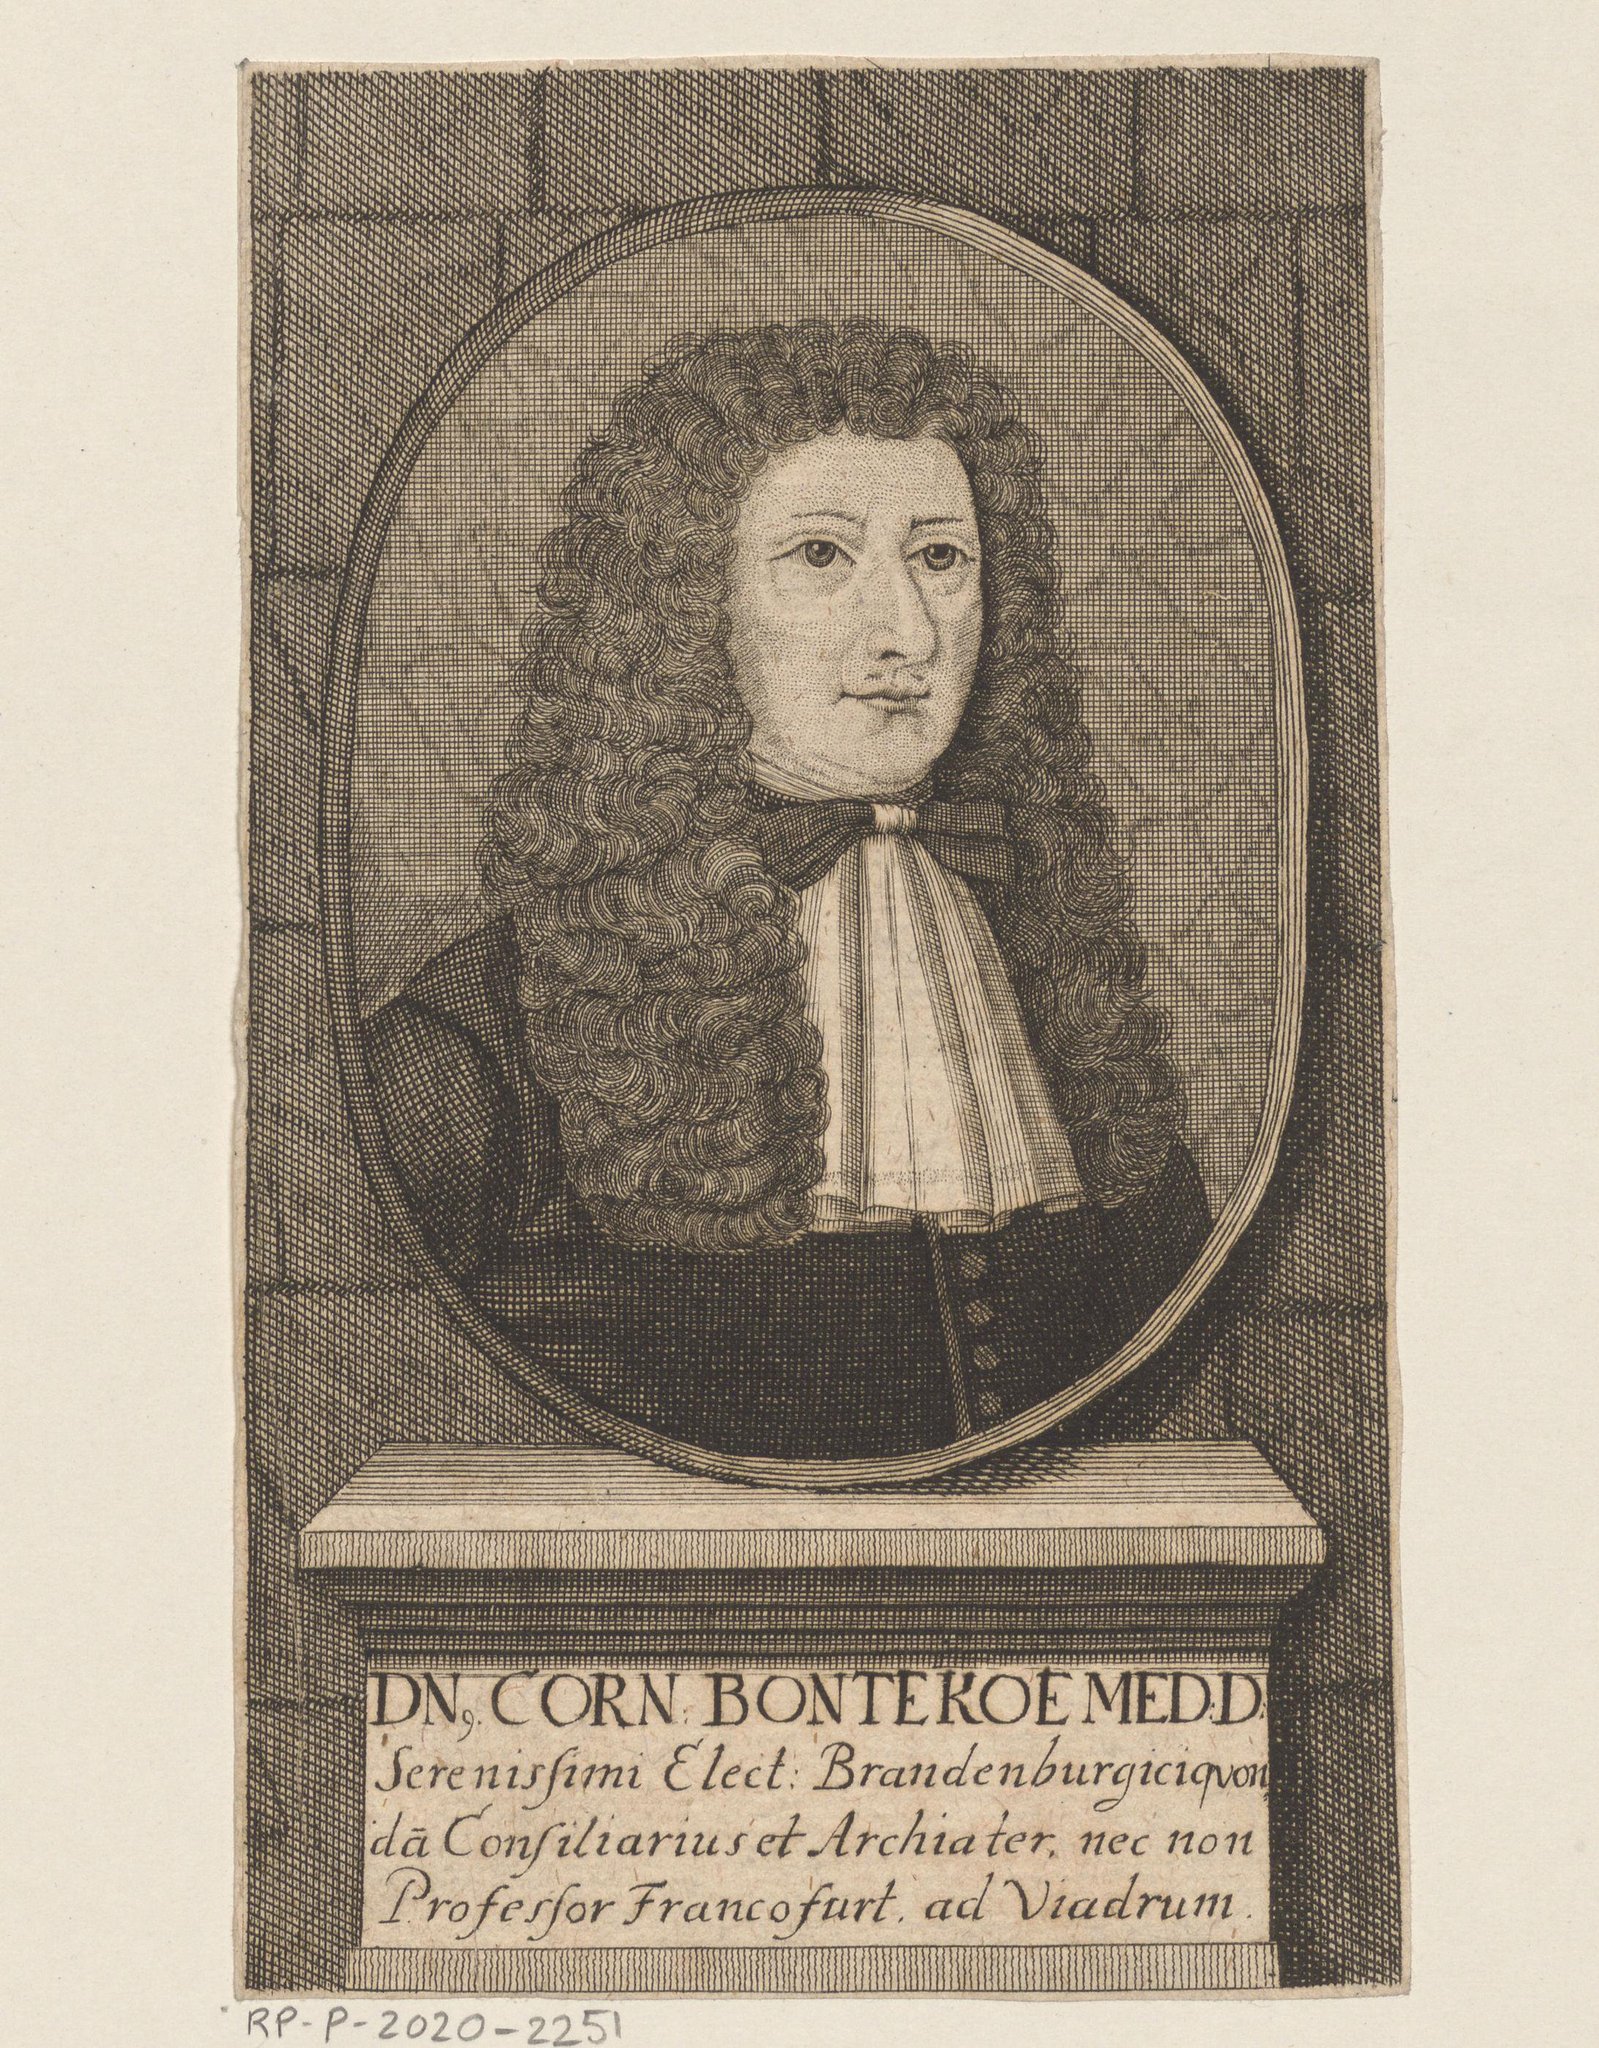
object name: print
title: Portret van Cornelis Bontekoe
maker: Anonymous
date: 1675-1725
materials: paper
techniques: engraving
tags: historical persons, physician, doctor